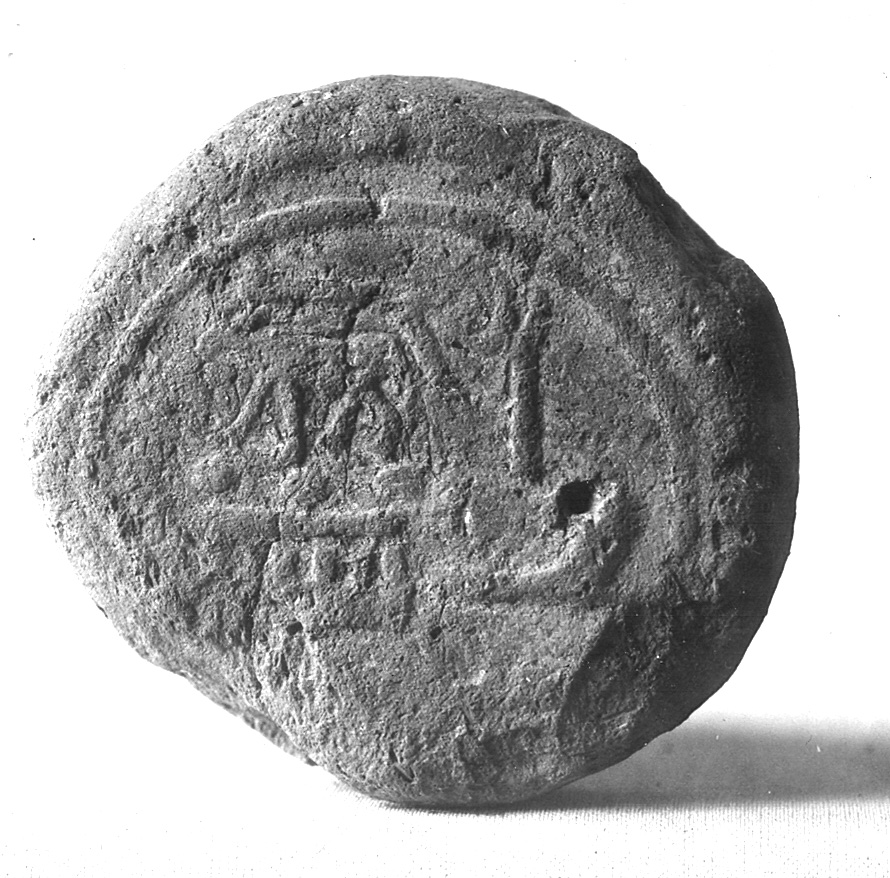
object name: cone, circular impression, userhat, overseer, cattle of amun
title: Funerary Cone of Overseer Userhat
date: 1550-1352 BCE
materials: pottery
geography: egypt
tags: hieroglyphs